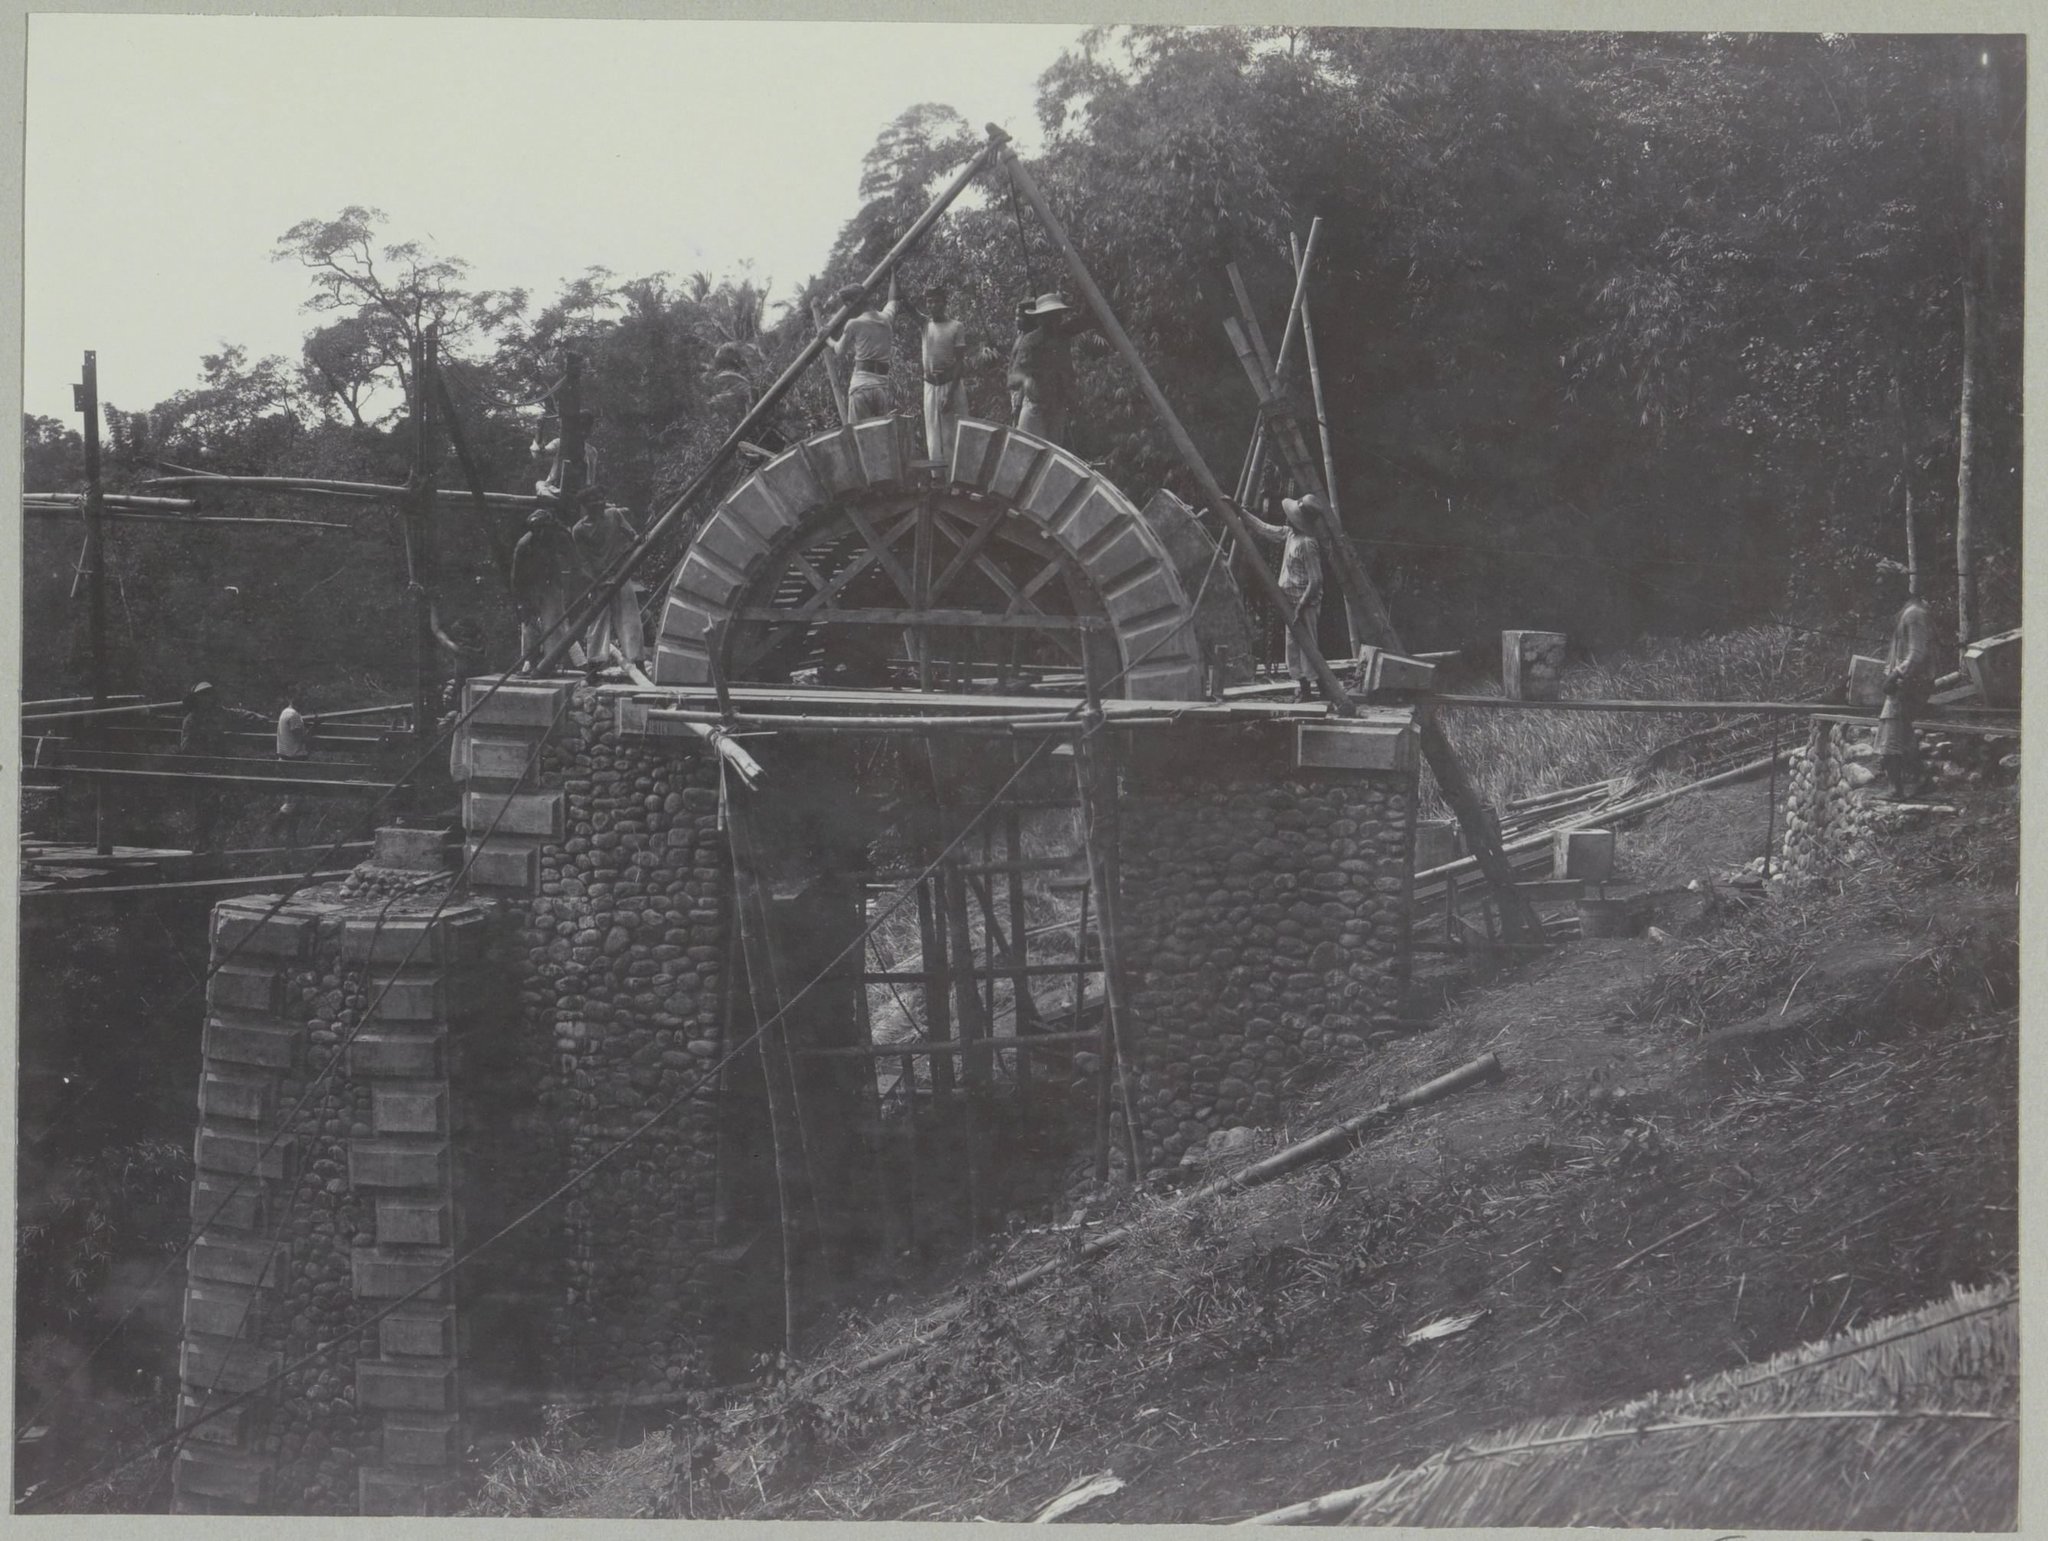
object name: photograph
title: Plaatsing van de sluitsteen op een spaarboog aan een landhoofd op de westelijke oever van de Kali Brantas ten zuiden van Malang (Photo XVII)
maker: Anonymous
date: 1890-1920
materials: cardboard, paper, photographic support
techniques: gelatin silver print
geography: java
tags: engineering, landscape with bridge, viaduct or aqueduct, bridge, building-site, java, dutch east indies, the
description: Foto met op de linkerpagina het bijbehorende bijschrift. Onderdeel van Fotoalbum met opnames van de bouw van een brug over de Kali Brantas ten zuiden van Malang op Java.